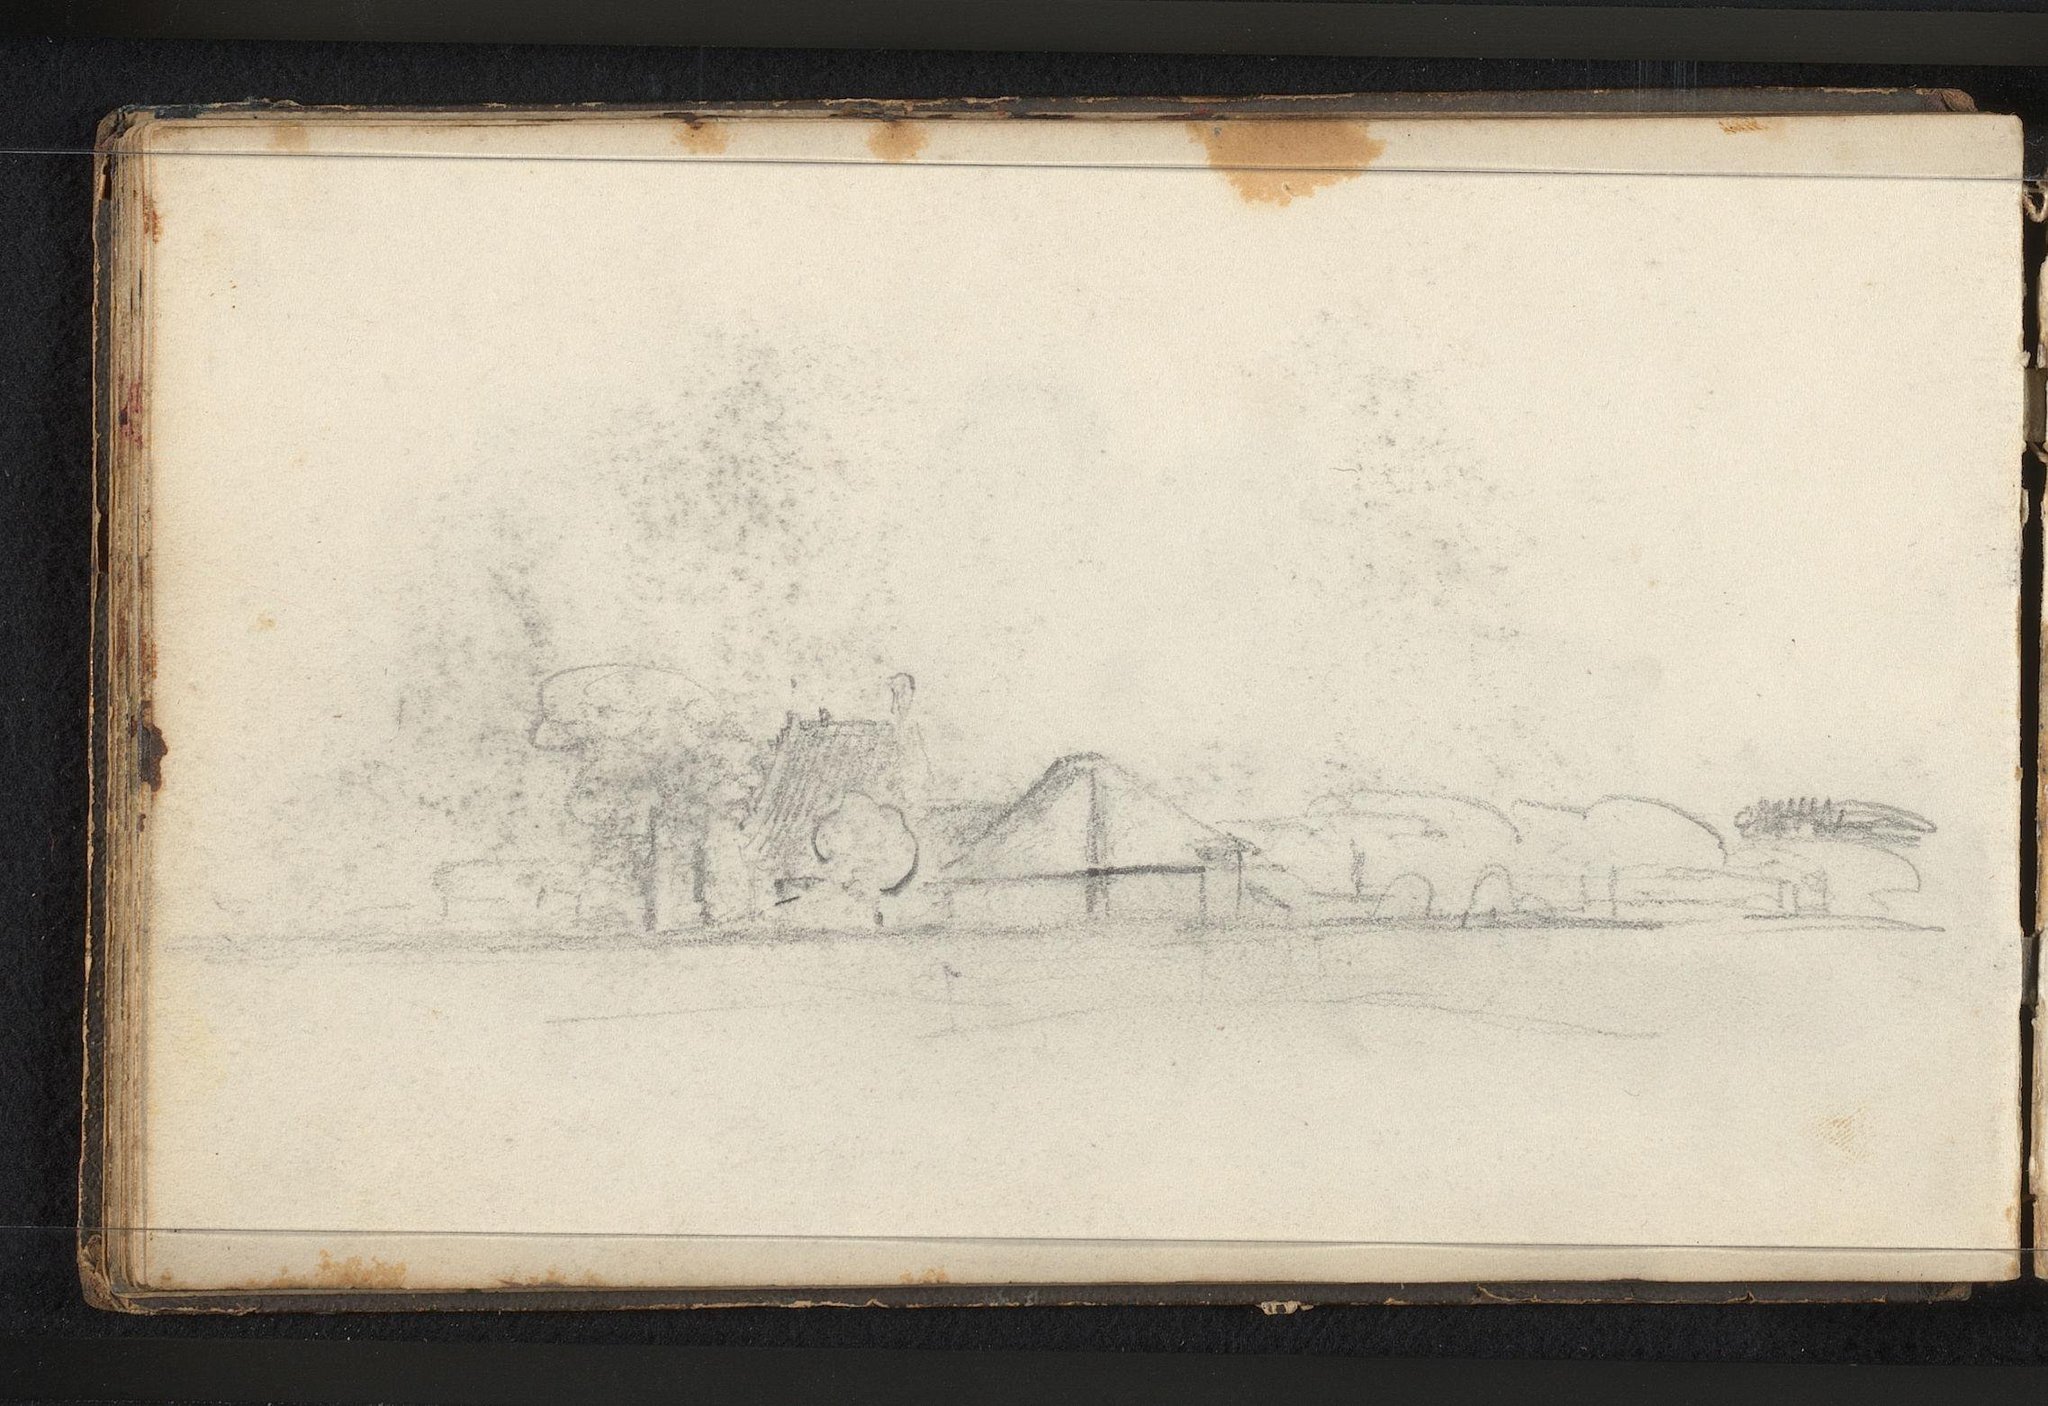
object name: sketchbook leaf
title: Landschap met gebouwen en bomen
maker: jan bedijs tom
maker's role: draughtsman, painter, print maker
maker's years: 1813-1894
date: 1828-1894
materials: paper, pencil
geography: the hague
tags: trees, landscapes, artist (in general) making preliminary designs, sketching, farm or solitary house in landscape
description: Pagina 17 verso uit een schetsboek met 54 bladen.